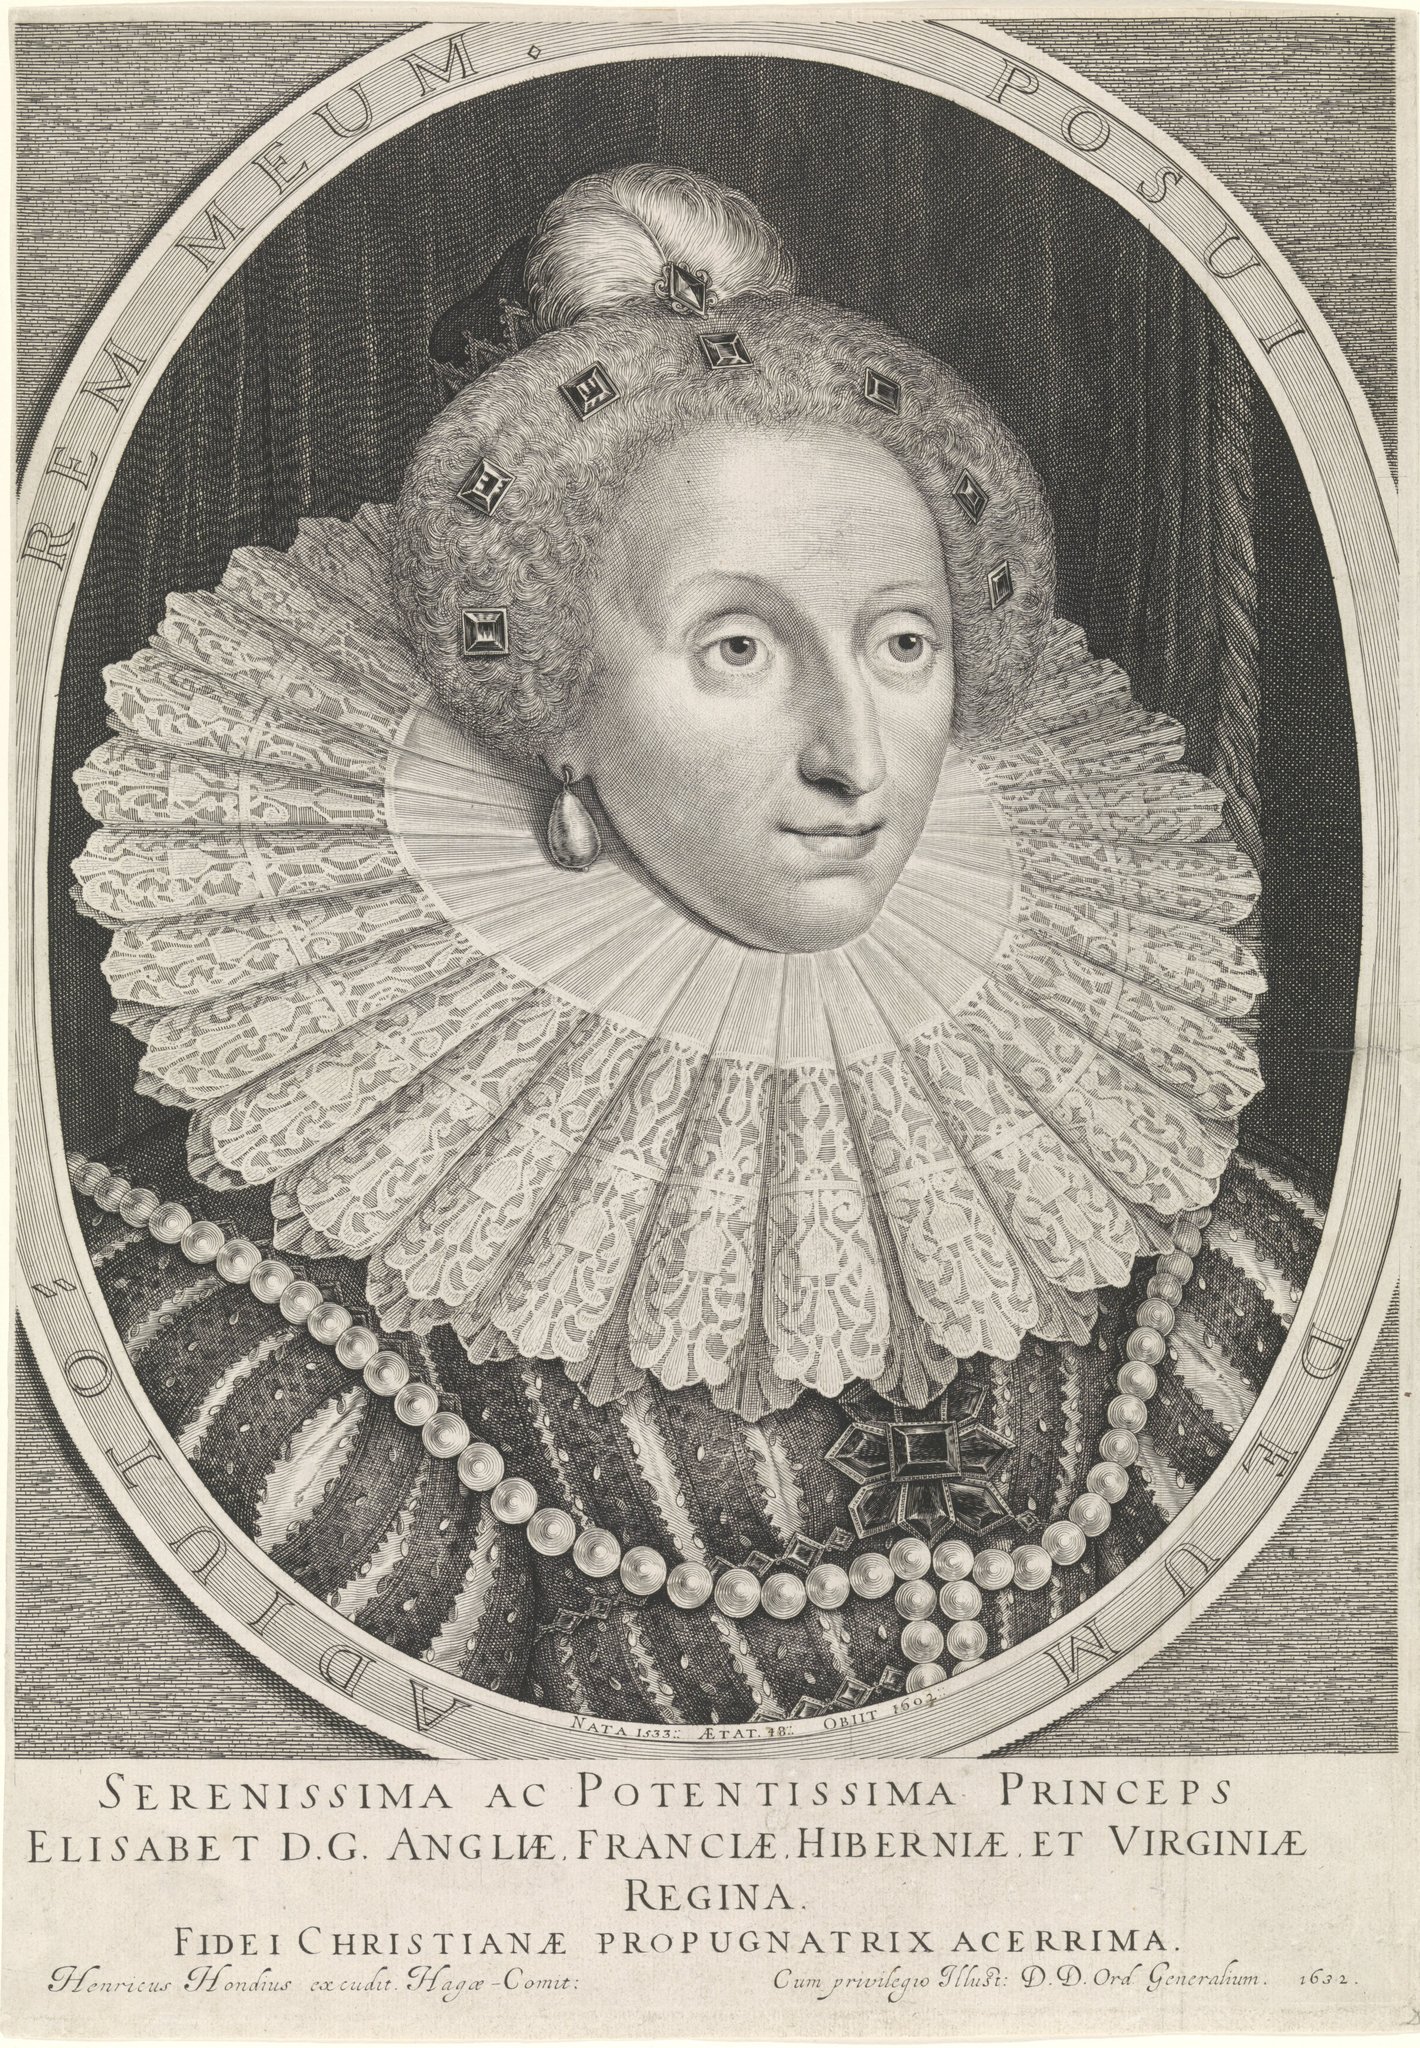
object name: print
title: Portret van Elizabeth I Tudor, koningin van Engeland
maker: hendrick hondius (i)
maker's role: draughtsman, print maker, publisher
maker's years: 1573-1650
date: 1632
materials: paper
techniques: engraving, etching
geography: the hague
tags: greenwich, richmond (surrey), koningin, elizabeth i tudor (koningin van engeland)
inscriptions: collector's mark: Lugt 2228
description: Buste naar rechts van Elizabeth I Tudor, koningin van Engeland op 48-jarige leeftijd in een ovale omlijsting met randschrift in het Latijn. Onder het portret vier regels in het Latijn.